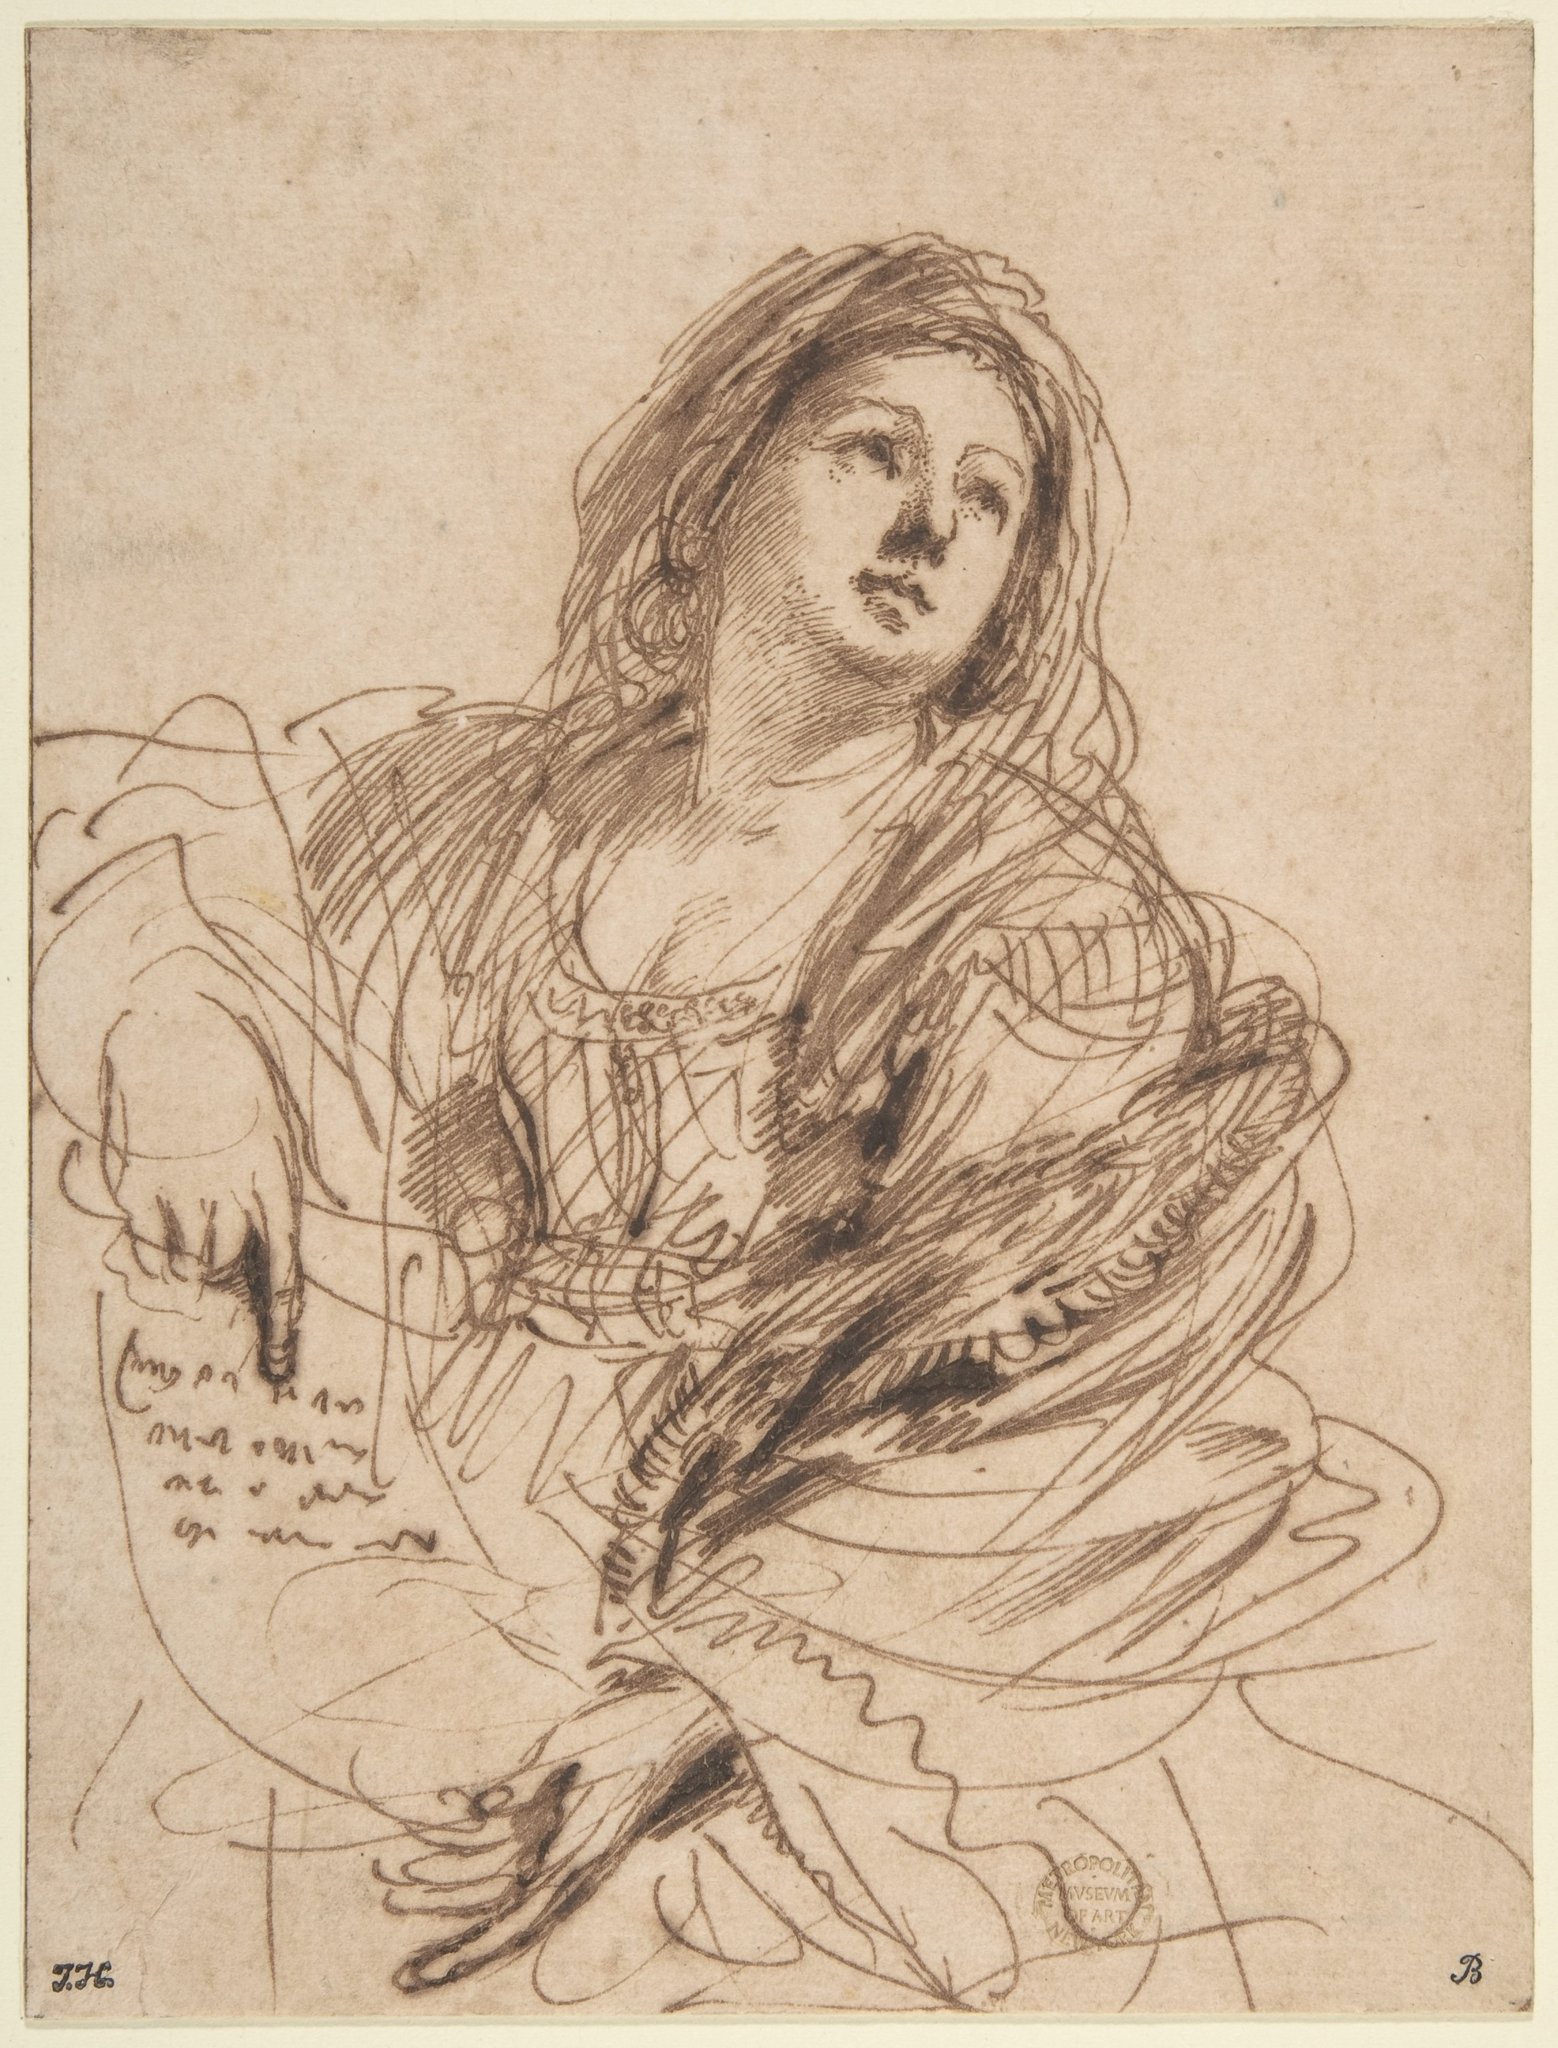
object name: drawing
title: A Sibyl Holding a Scroll (Study for the Cimmerian Sibyl)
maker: guercino (giovanni francesco barbieri)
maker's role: artist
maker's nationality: italian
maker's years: 1591-1666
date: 1638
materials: ink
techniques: pen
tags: scrolls,sibyl